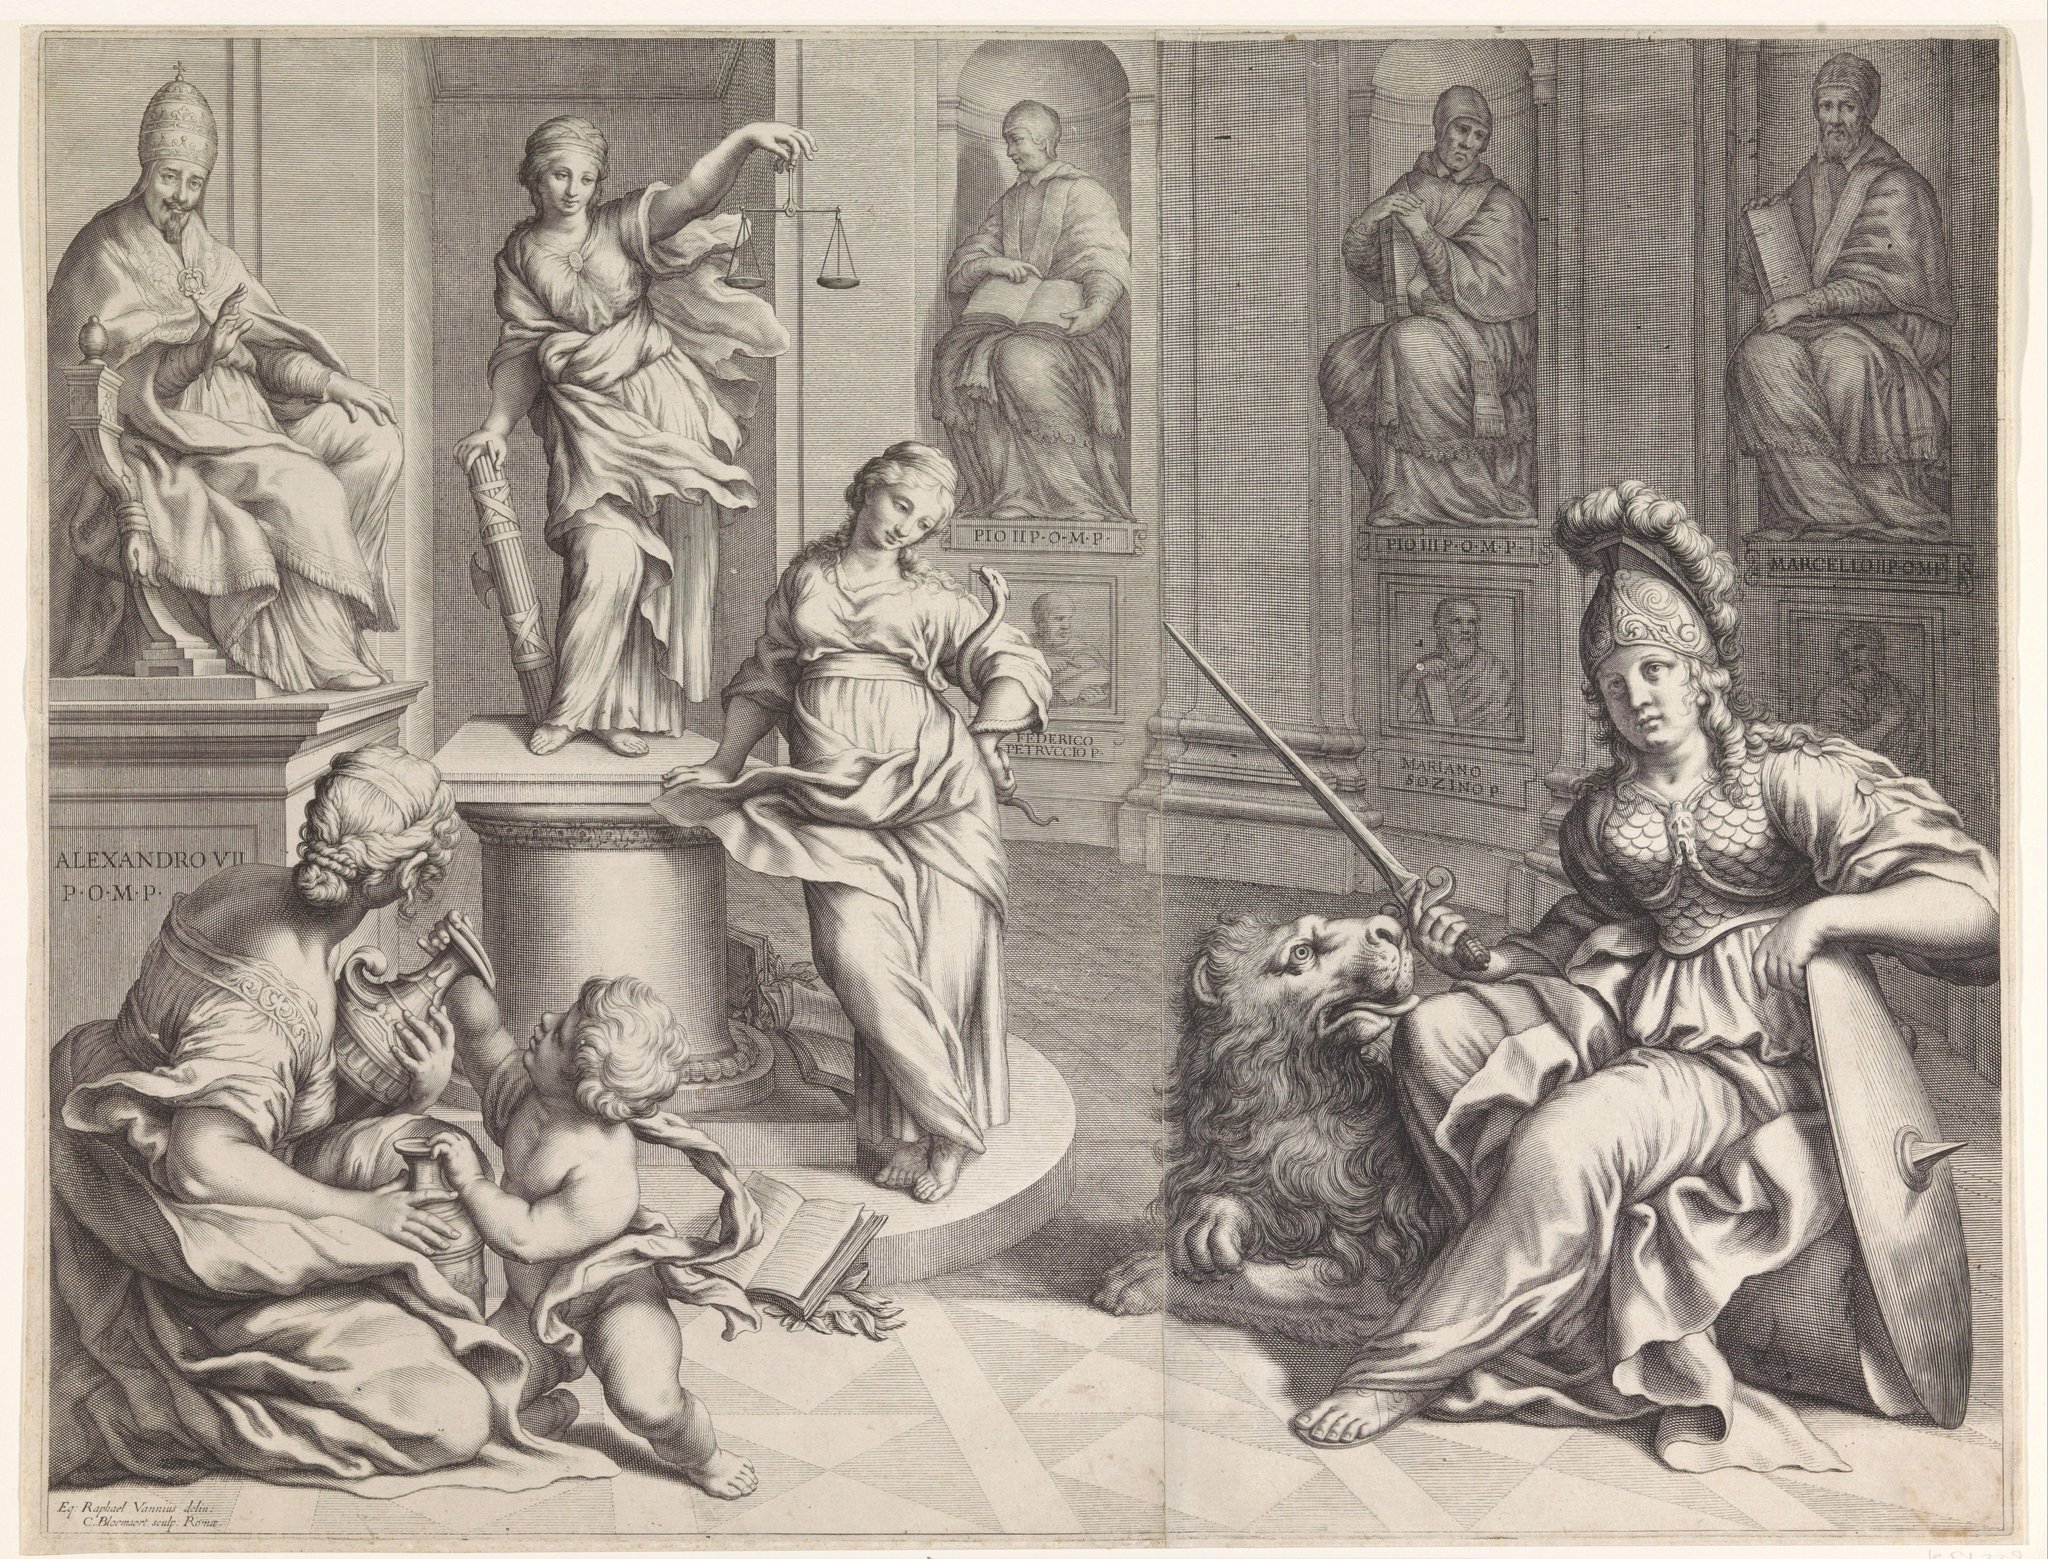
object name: print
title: Paus Alexander VII zit op een troon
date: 1655-1692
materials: paper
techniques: engraving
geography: rome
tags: alexander vii, (story of) minerva (pallas, athena), historical persons, justitia (justice) as roman personification, pope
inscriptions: collector's mark: Lugt 240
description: Paus Alexander VII zit op een troon en maakt een zegegebaar. Een moeder met haar kind kijken naar hem op. Justitia staat op een piëdestal naast de paus. Naast haar staat een jonge vrouw met een slang. Minerva met wapenrusting en zwaard zit op de leeuw. In nissen aan de wand standbeelden van overleden pausen.